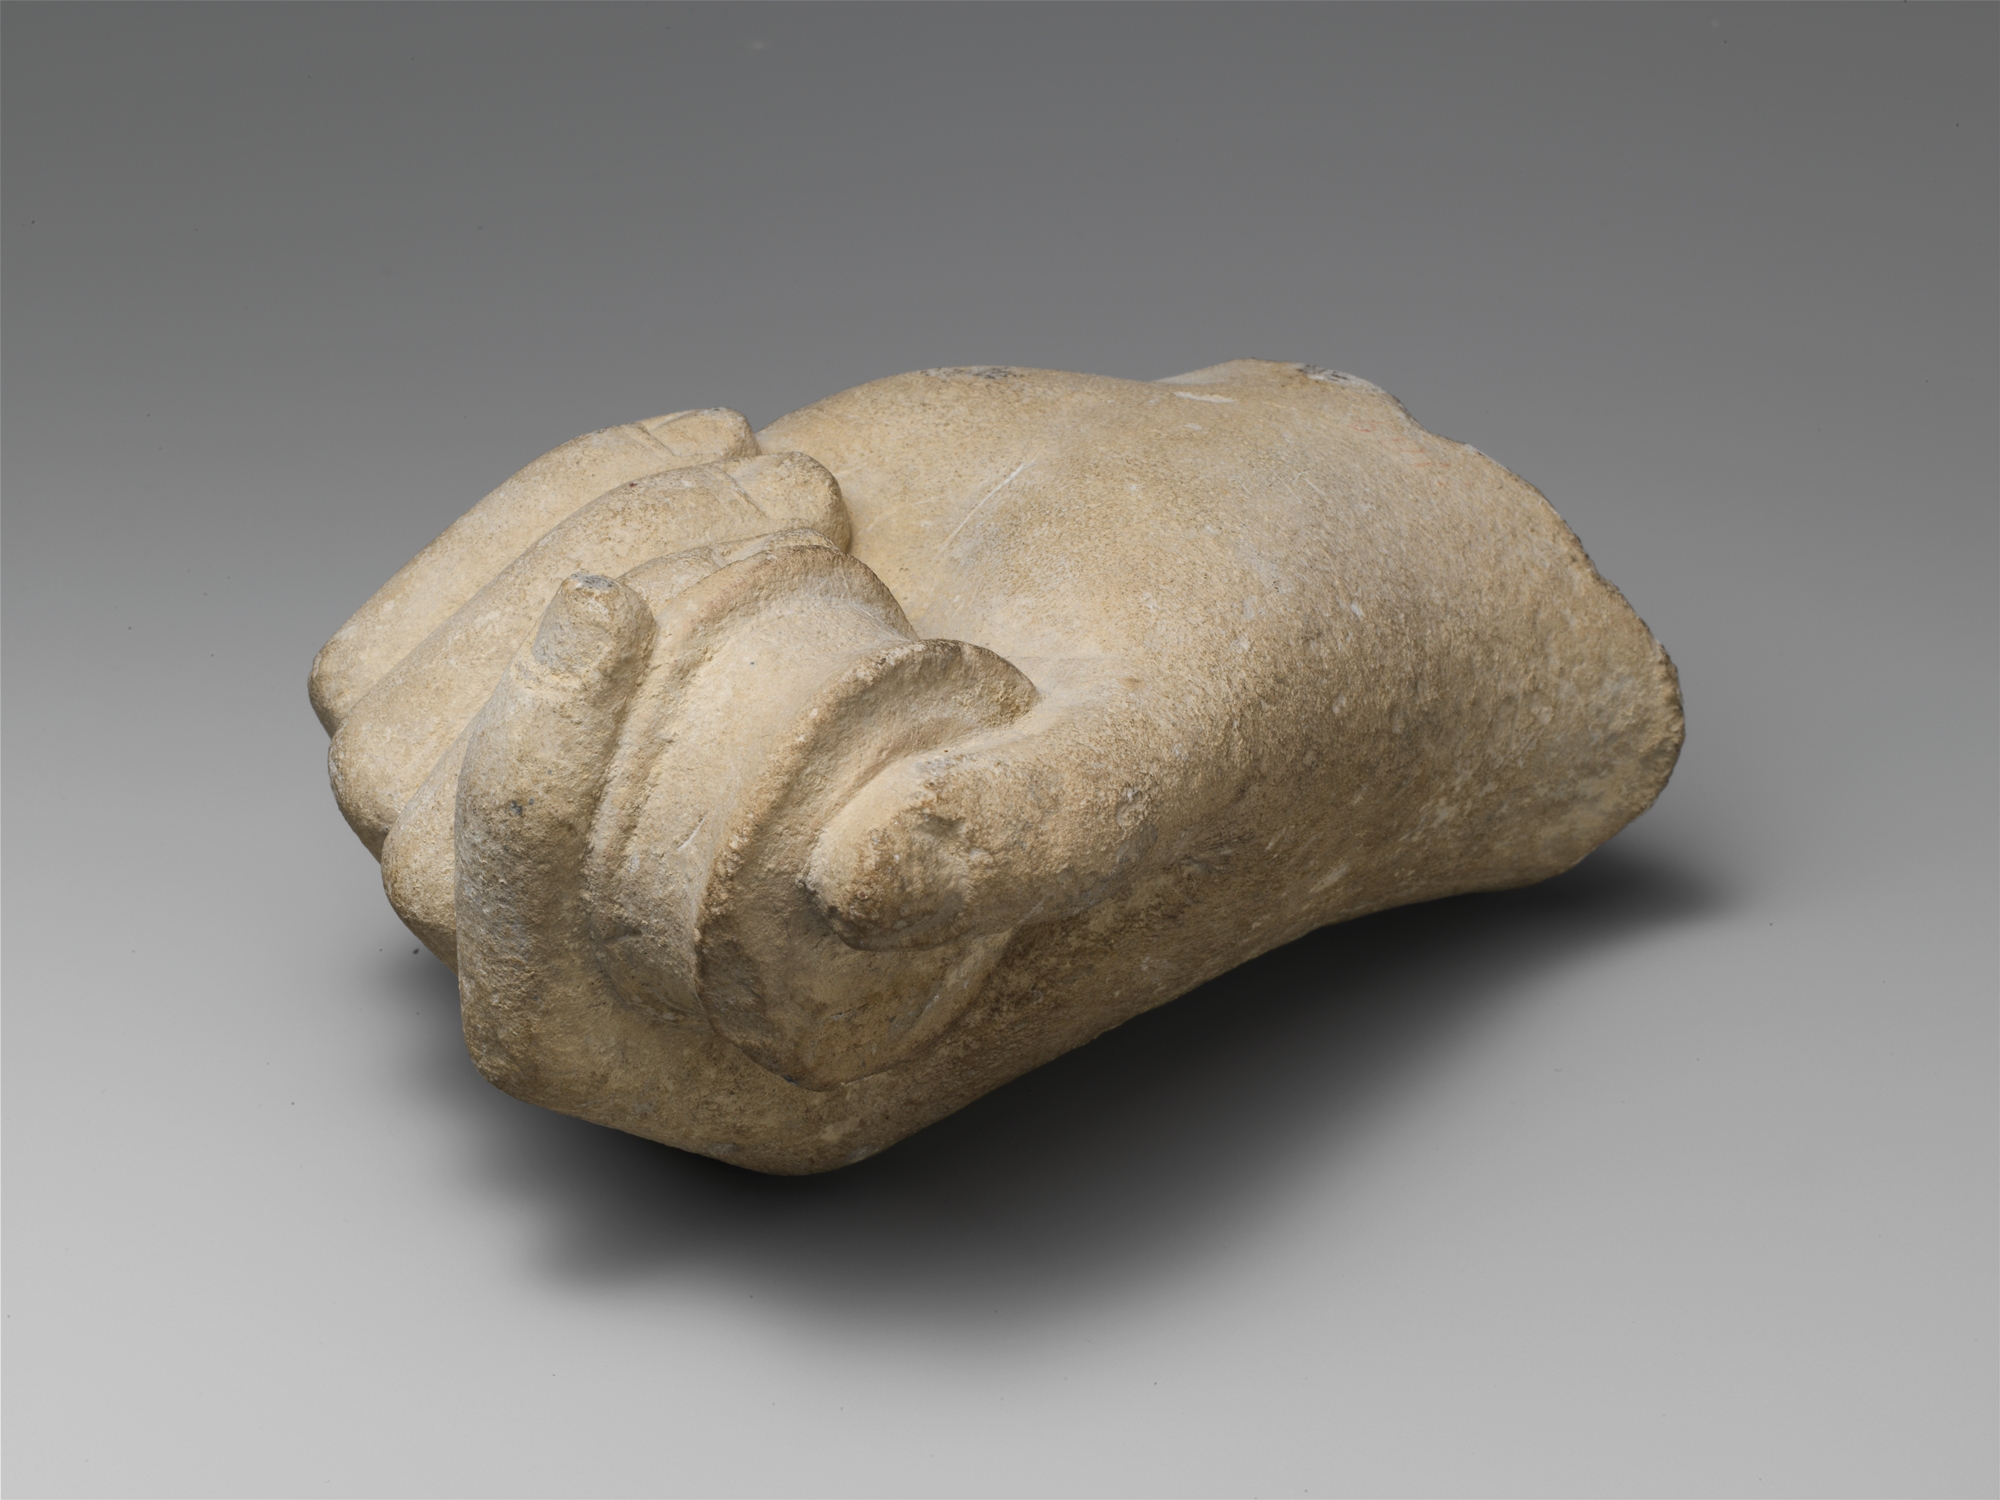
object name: statue fragment of a hand holding a pyxis or bobbin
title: Limestone statue fragment of a hand holding a pyxis or bobbin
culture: cypriot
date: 300-1 BCE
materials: limestone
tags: hands